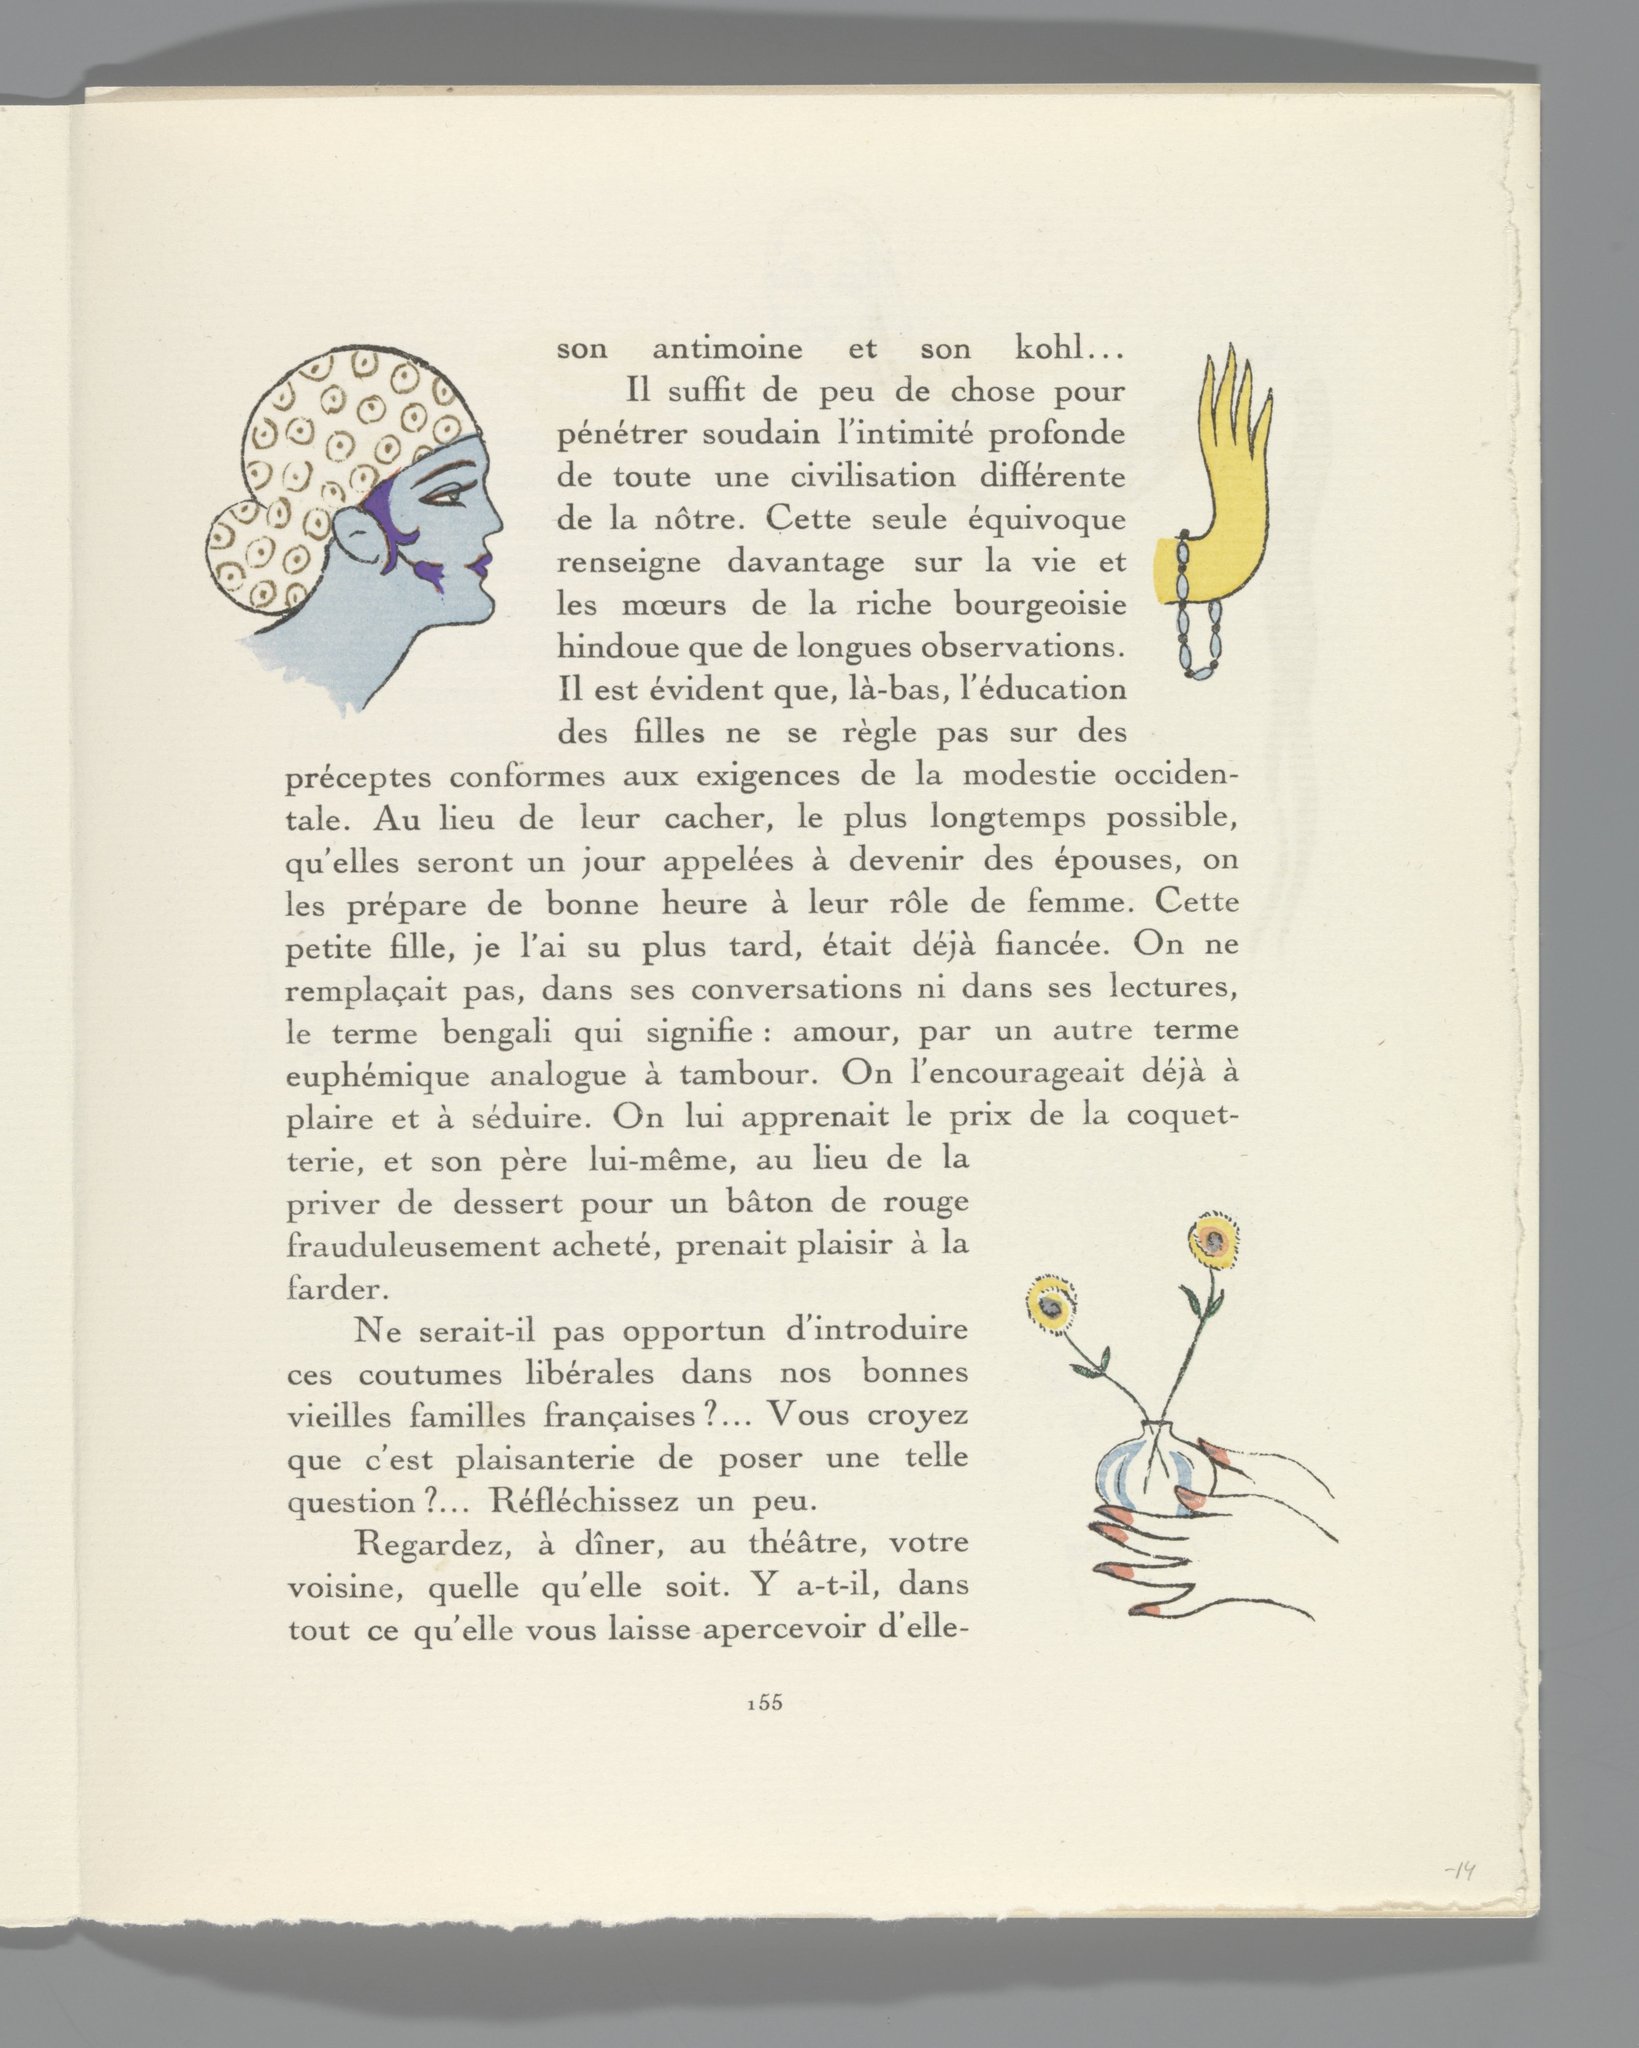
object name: fashion print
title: Gazette du Bon Ton, 1914 - No. 5, pag. 155: La Palette des Dames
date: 1914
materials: paper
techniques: hand coloring, letterpress printing, lithograph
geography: london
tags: fashion plates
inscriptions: date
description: La Palette des Dames. Tekst met ills. Pag. 155 uit Gazette du Bon Ton 1914, No. 5.